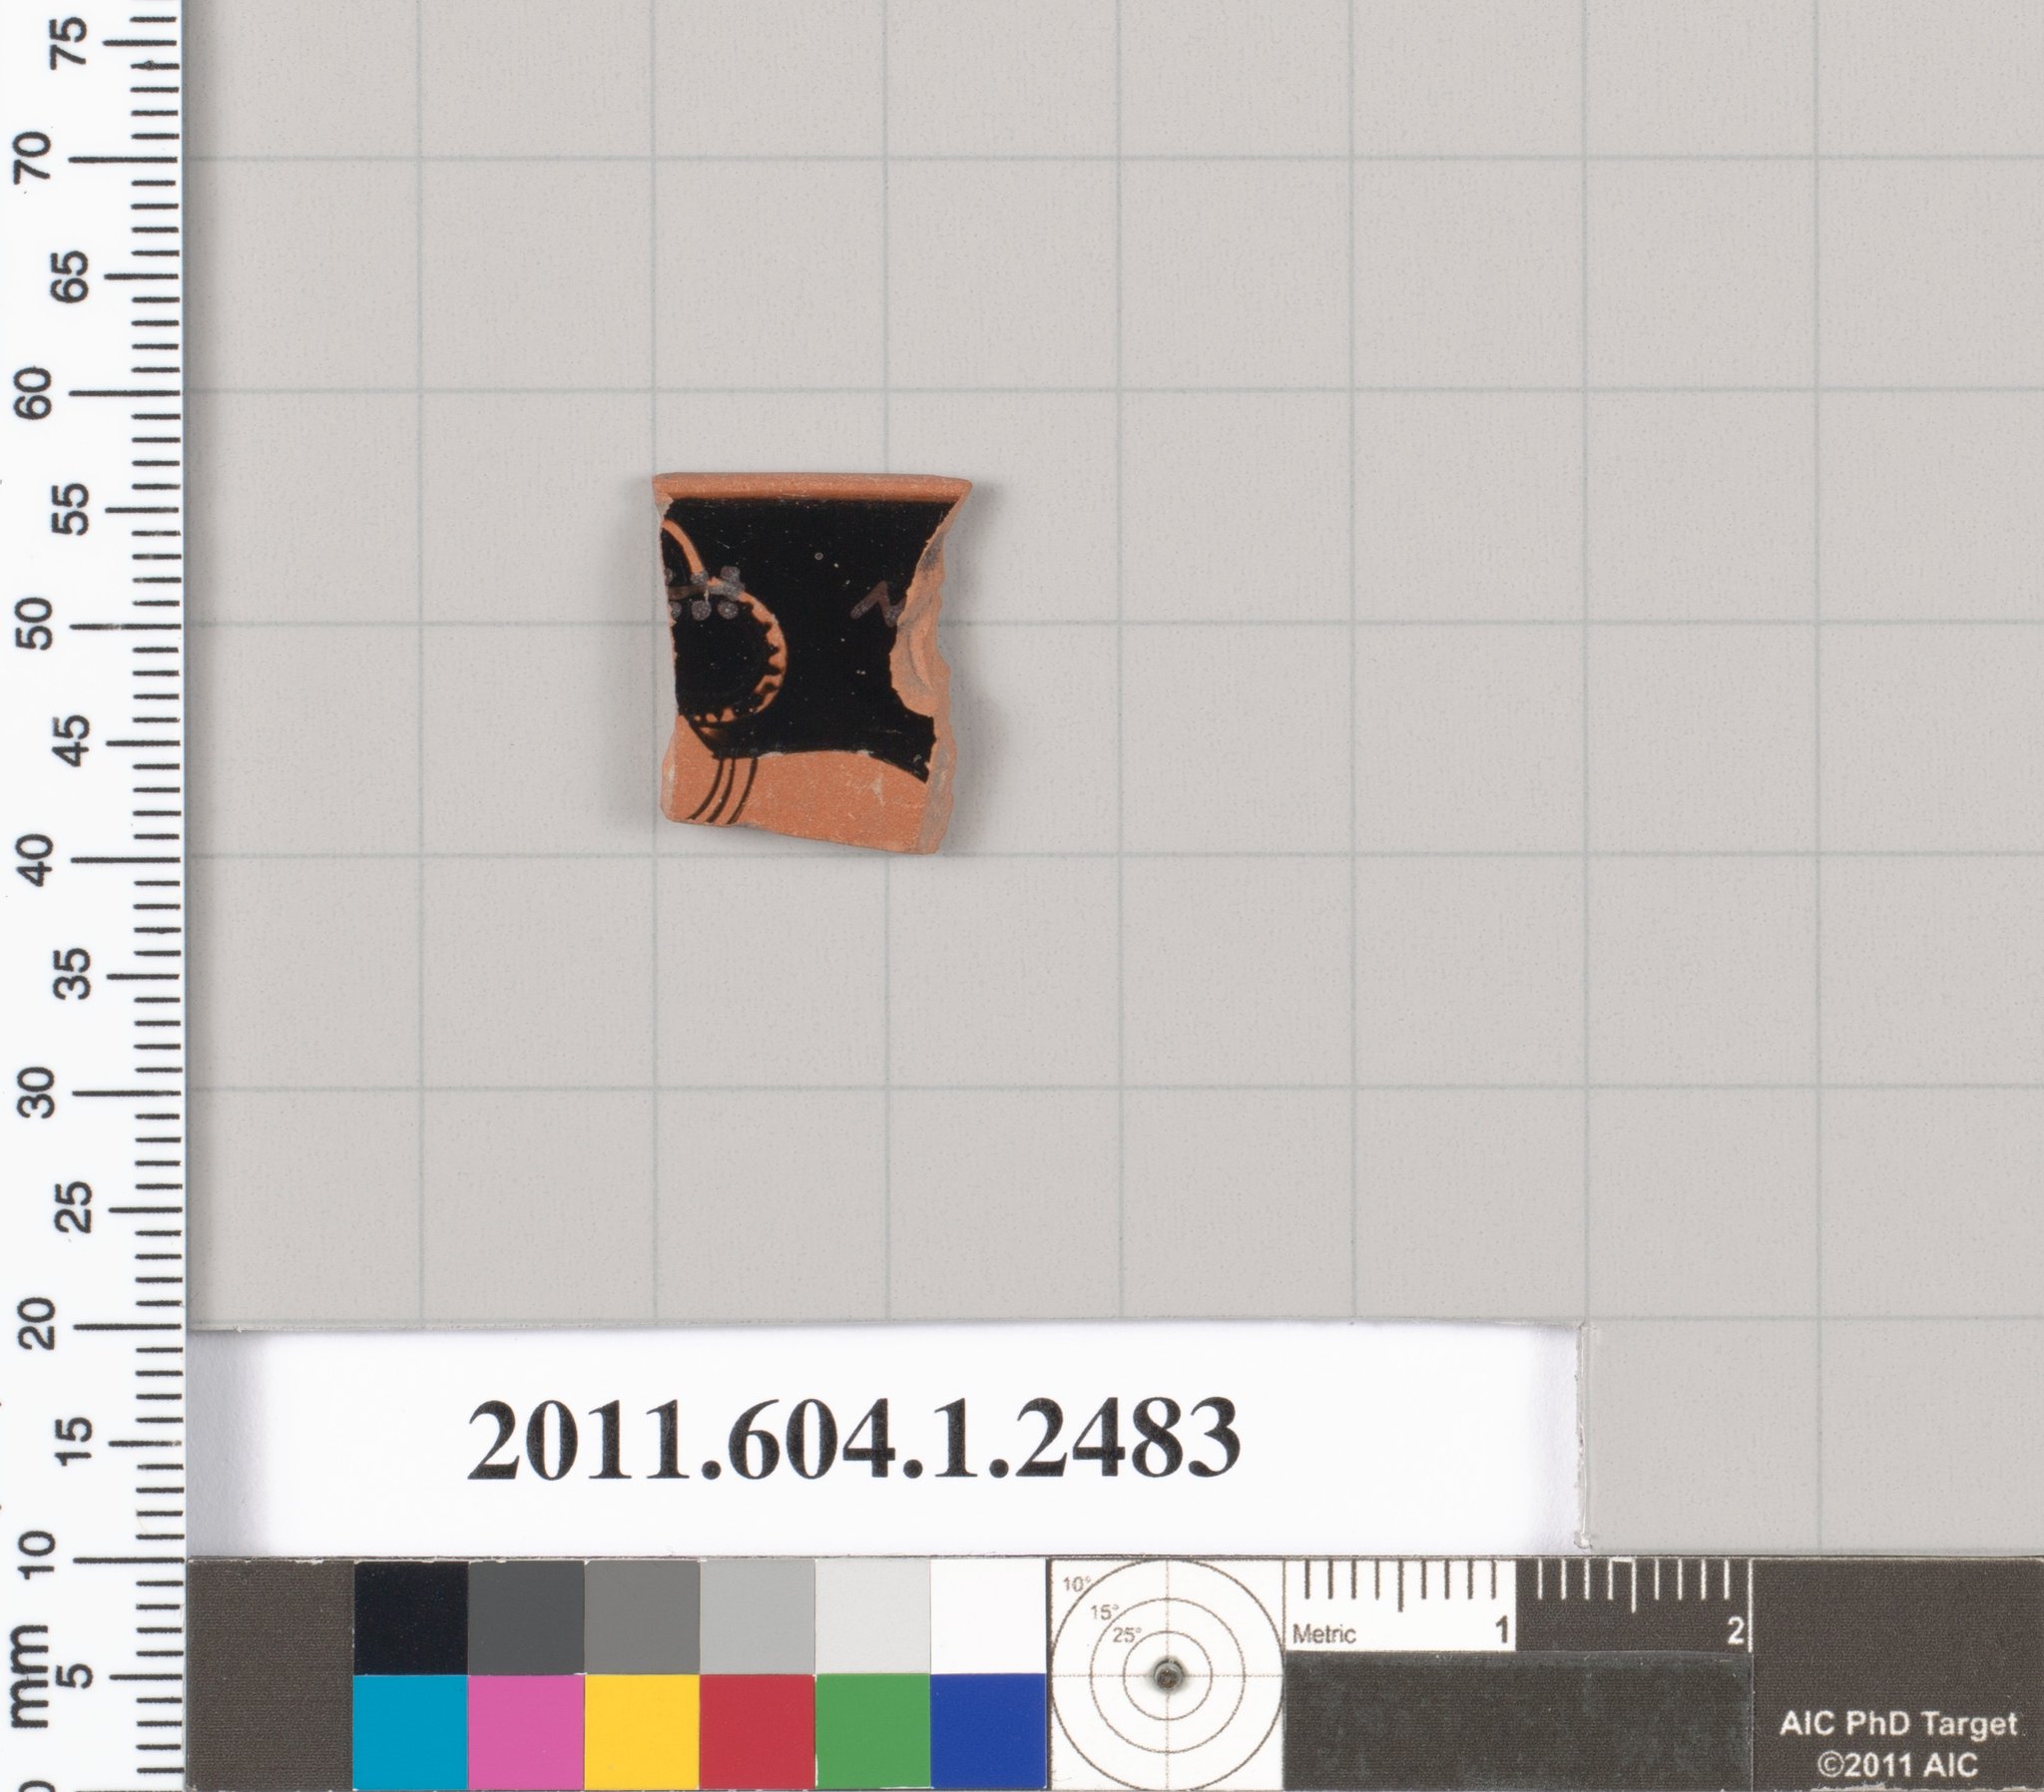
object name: kylix fragment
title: Terracotta rim fragment of a kylix (drinking cup)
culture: greek, attic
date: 520-500 BCE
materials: terracotta